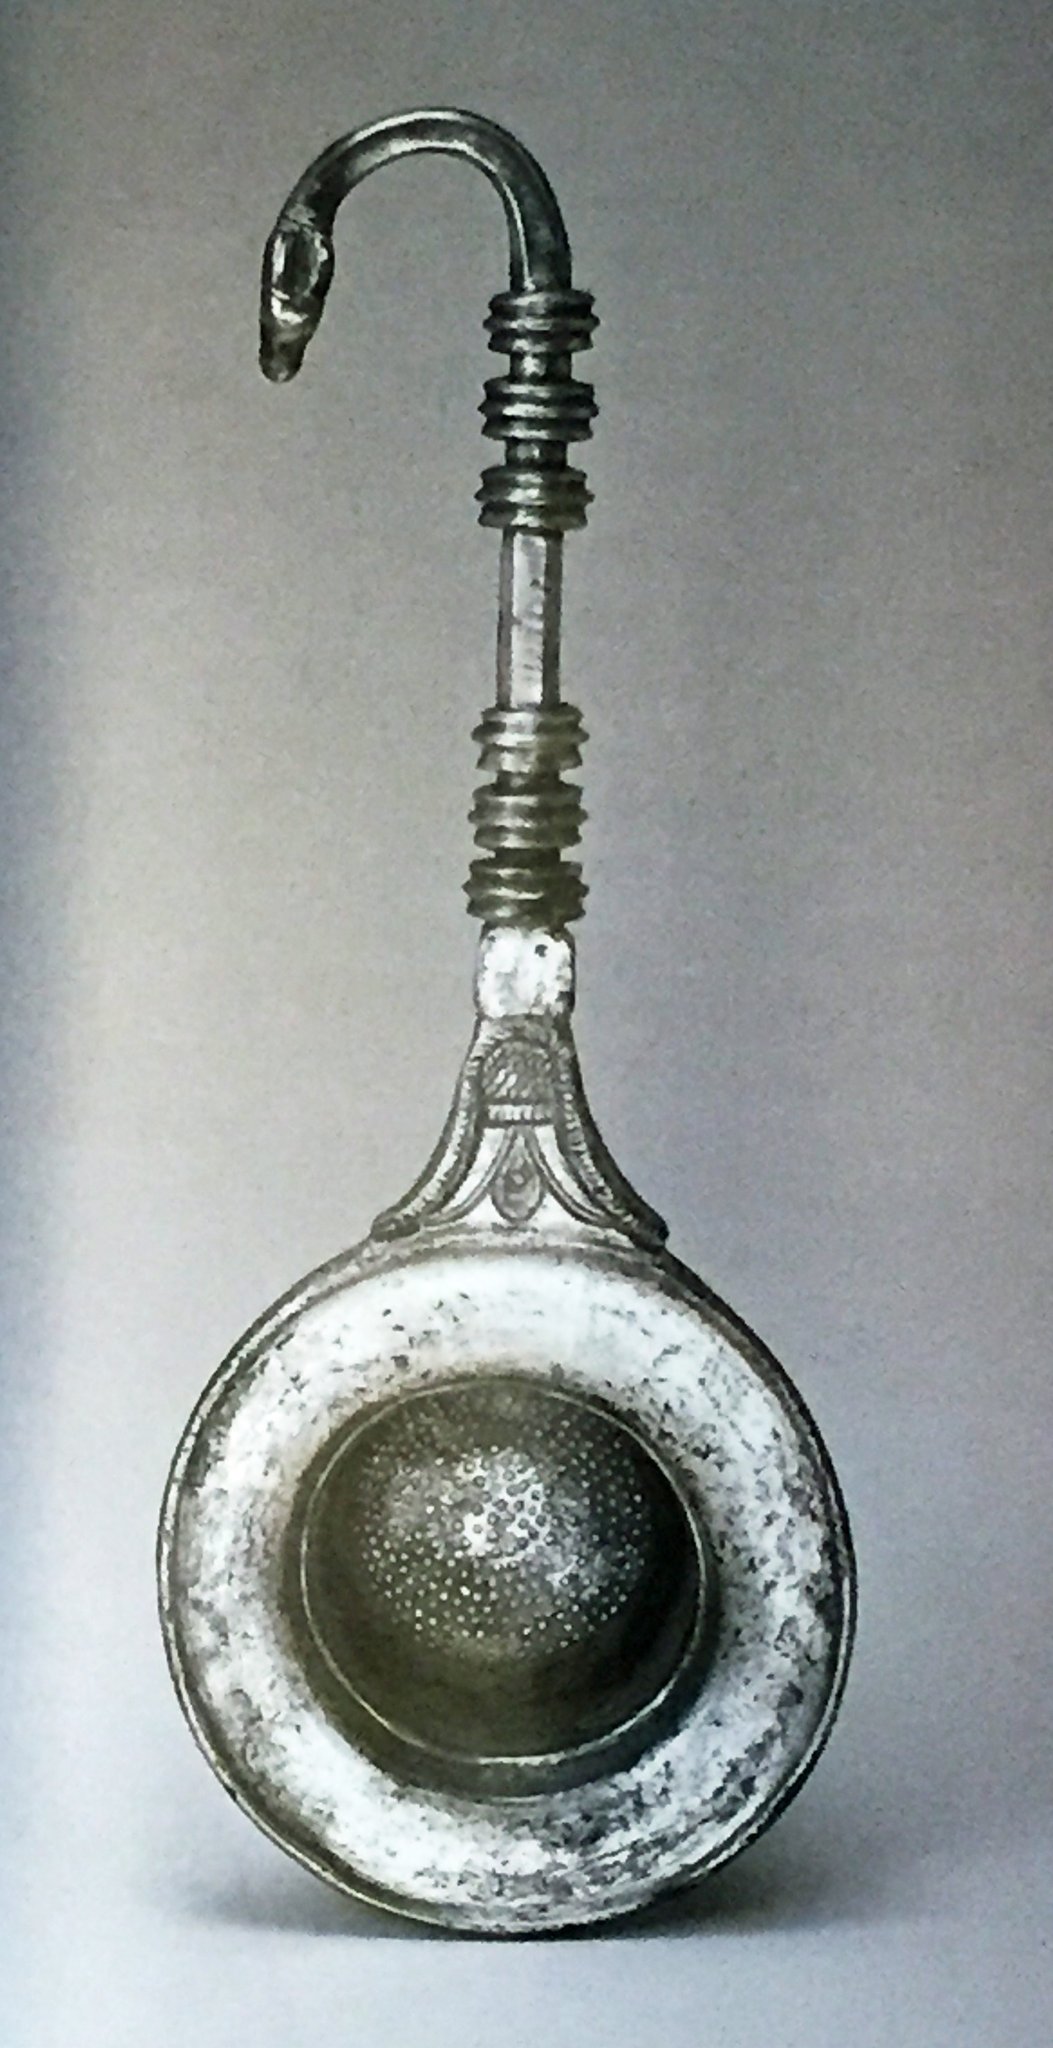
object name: strainer for wine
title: Silver strainer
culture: east greek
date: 600-501 BCE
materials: silver